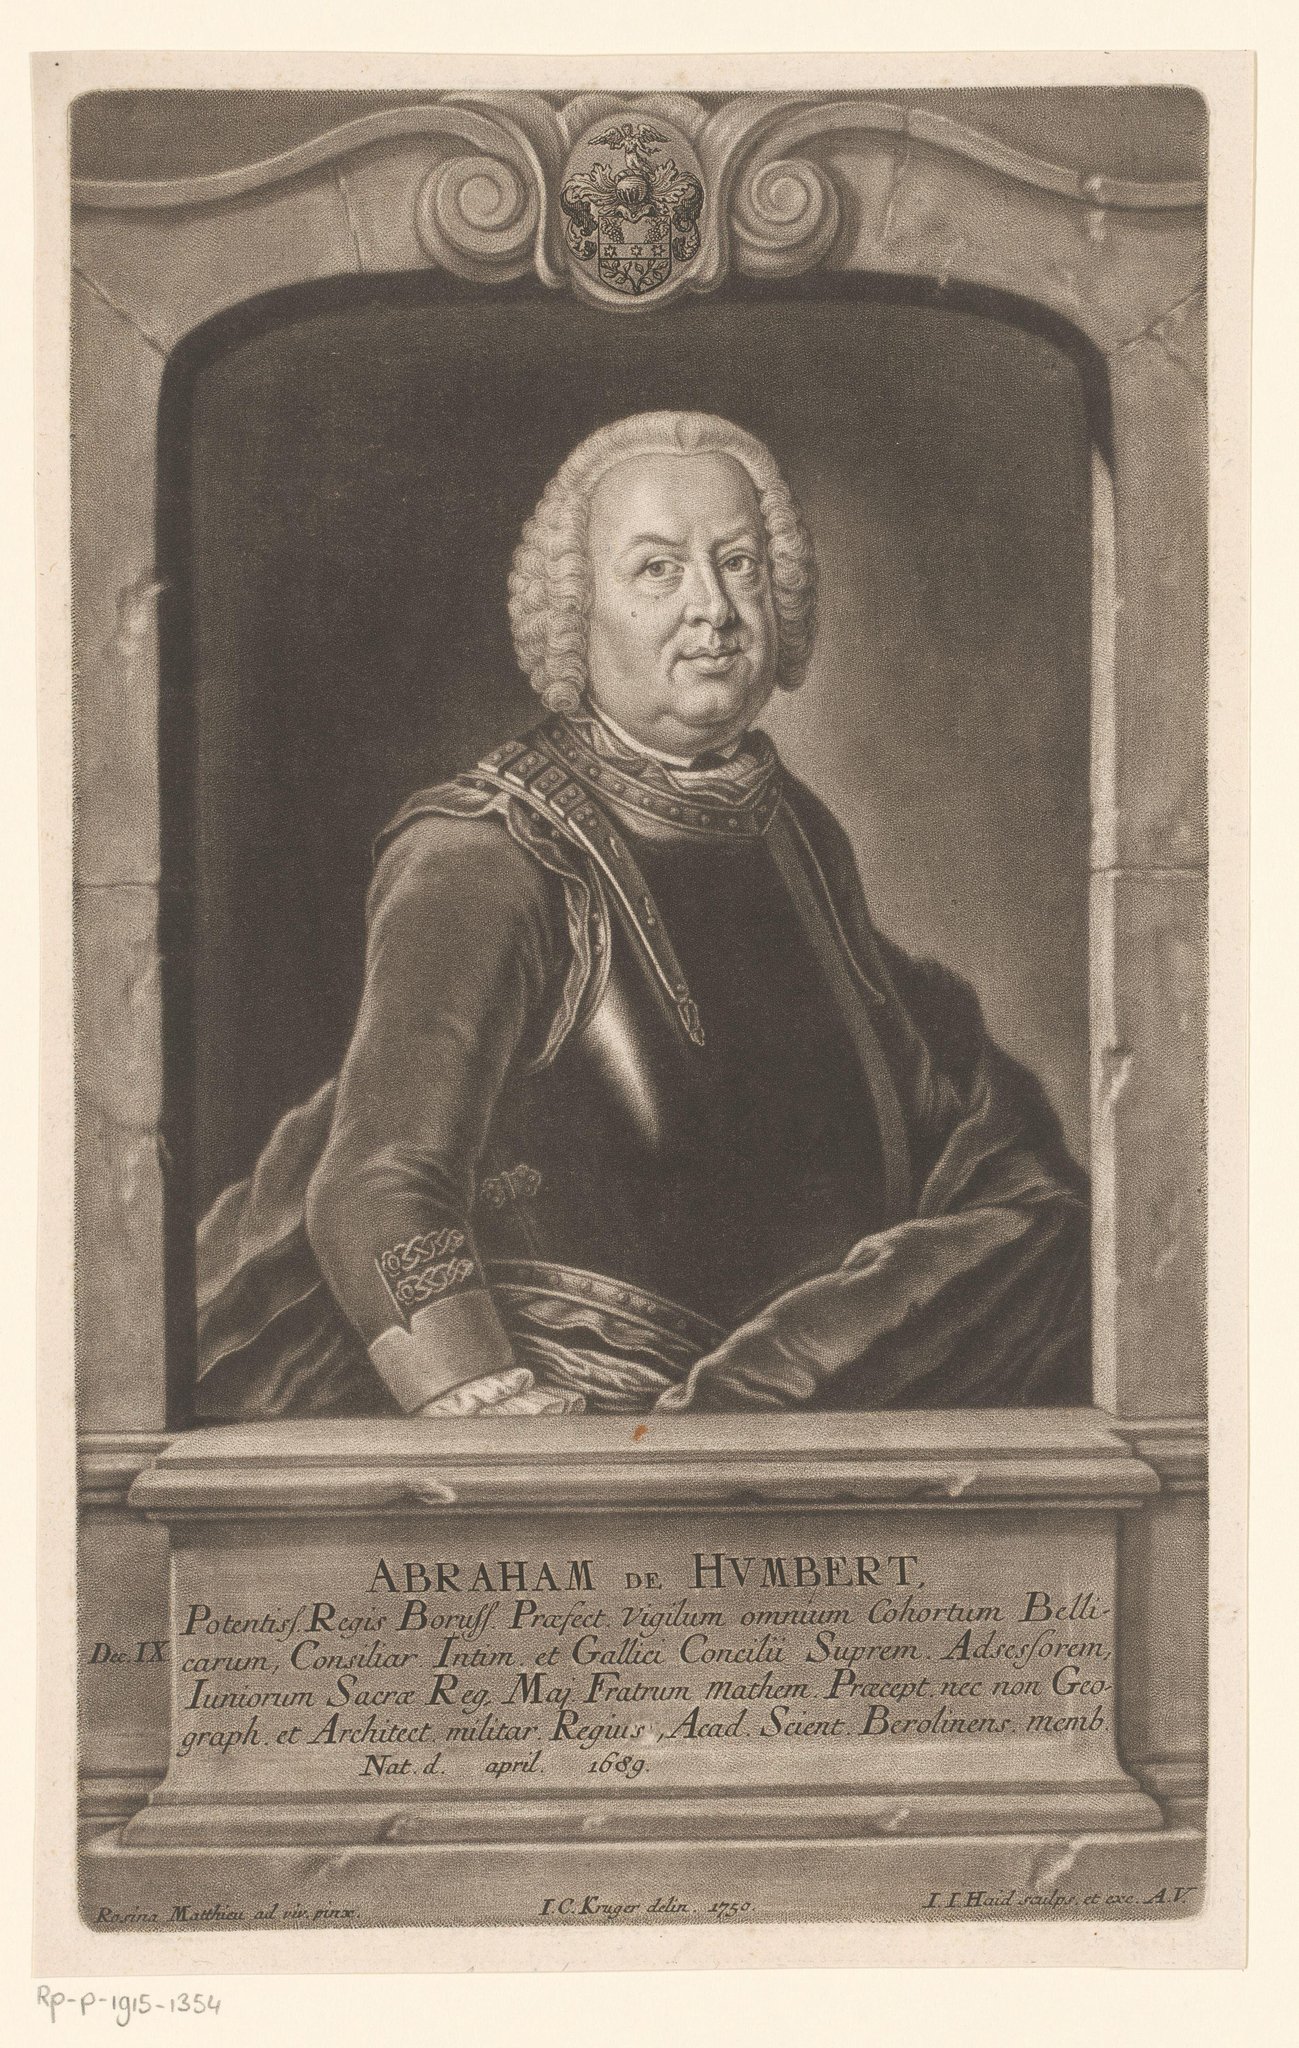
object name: print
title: Portret van Abraham von Humbert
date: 1750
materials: paper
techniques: mezzotint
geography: augsburg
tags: armour, historical persons, armorial bearing, heraldry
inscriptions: collector's mark: Lugt 2228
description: Prent gebruikt voor: Brucker, Jacob. Bildersal heutiges Tages lebender und durch Gelahrheit berühmter Schrifftsteller. Augsburg: Johann Jacob Haid, 1752.